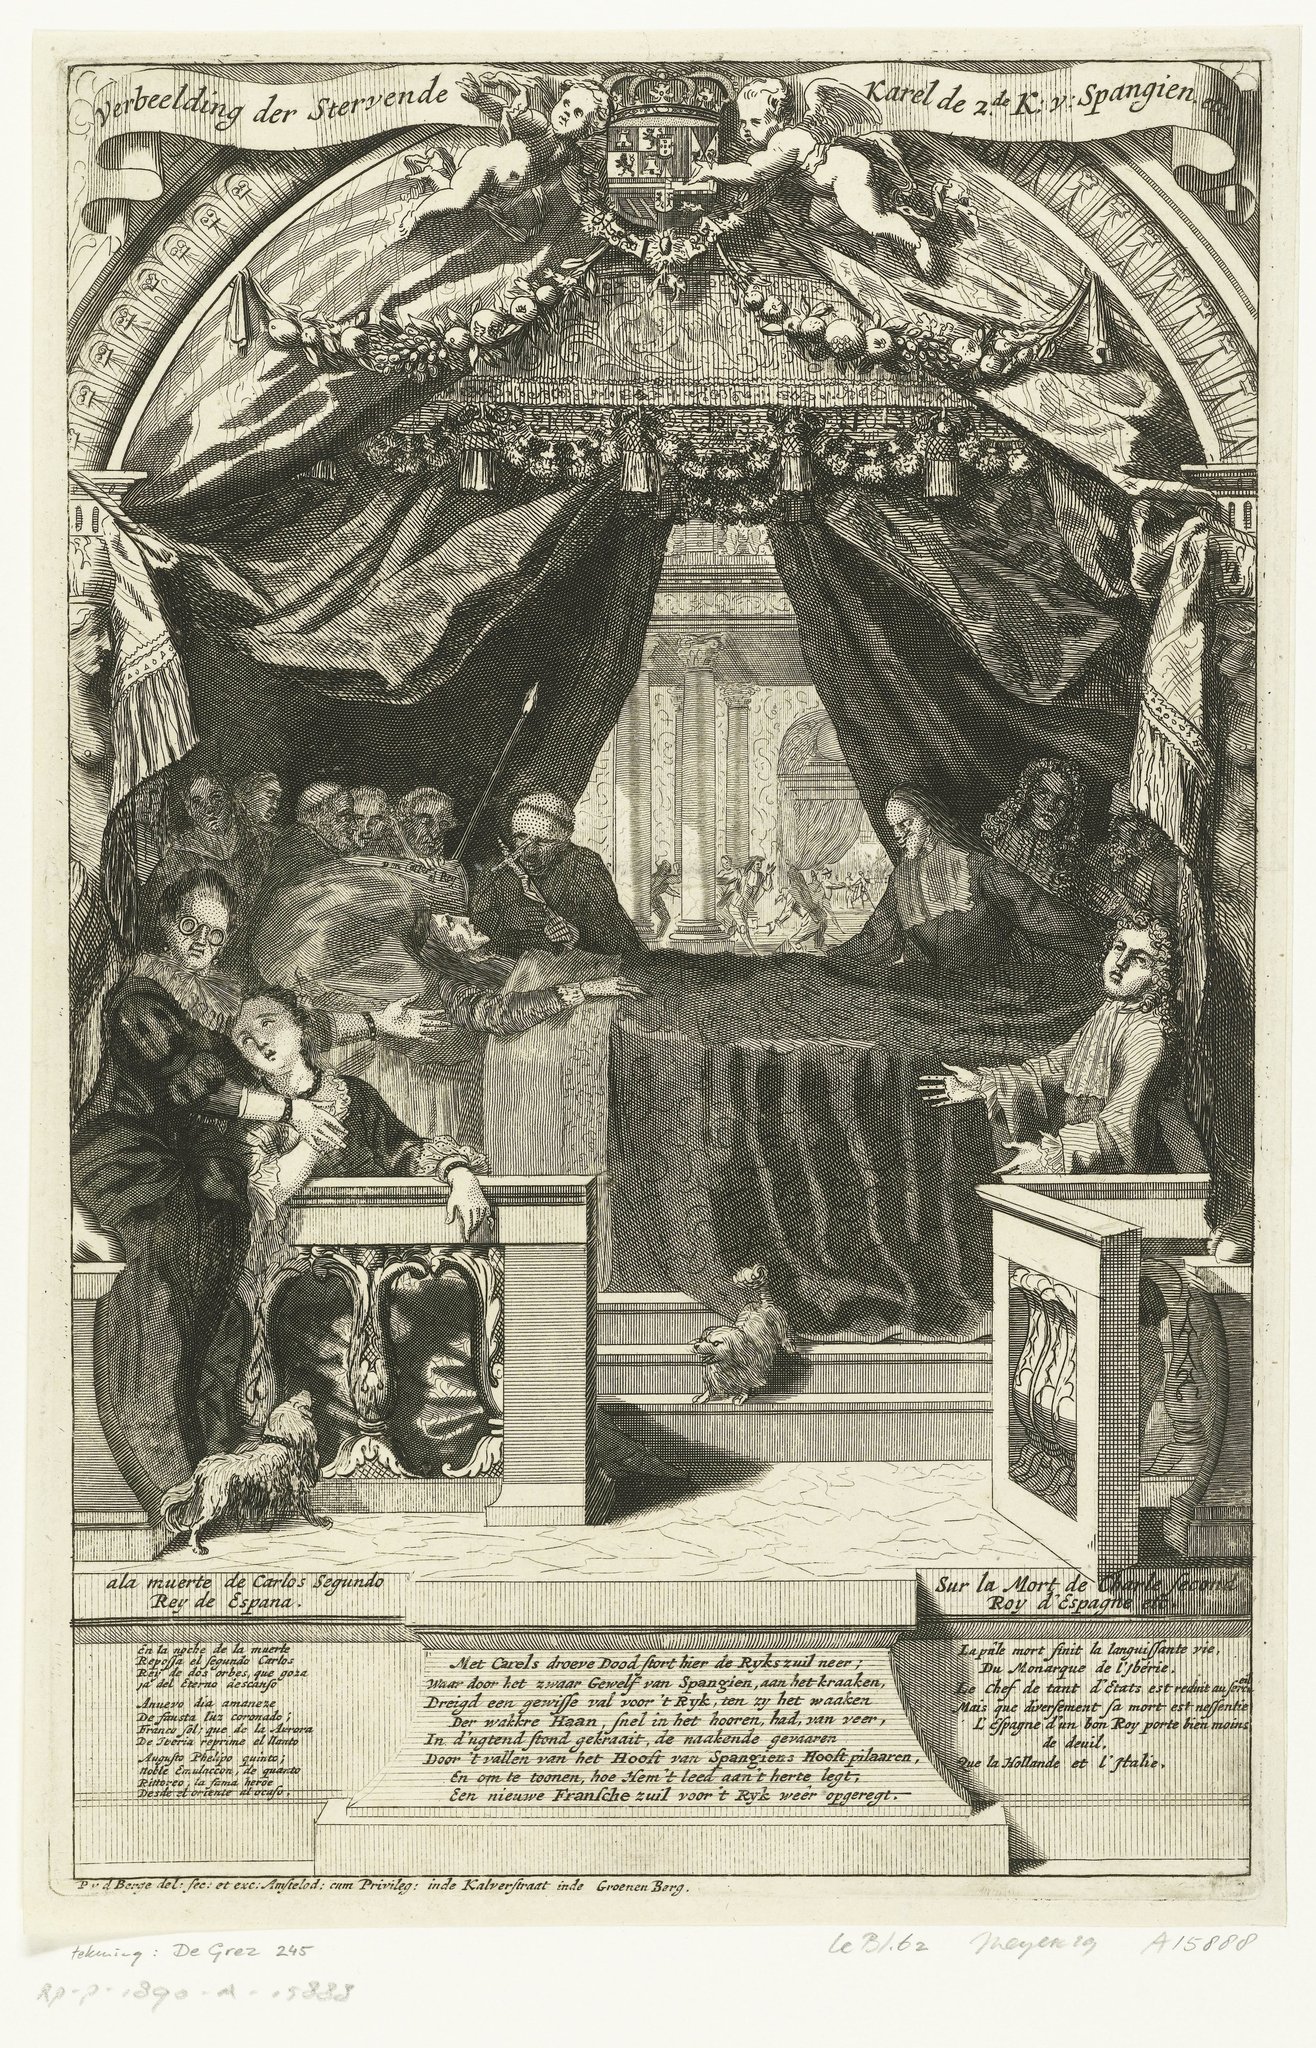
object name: print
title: Sterfbed van Karel II, koning van Spanje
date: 1700-1702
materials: paper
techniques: engraving, etching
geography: amsterdam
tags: karel ii (koning van spanje), deathbed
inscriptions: collector's mark: Lugt 2228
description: Karel II, koning van Spanje ligt in bed, op het punt te overlijden. Een priester toont hem een crucifix. Om het bed staan leden van het hof. Onder de voorstelling een vers op Karel's dood, in het Spaans, Nederlands en Frans.